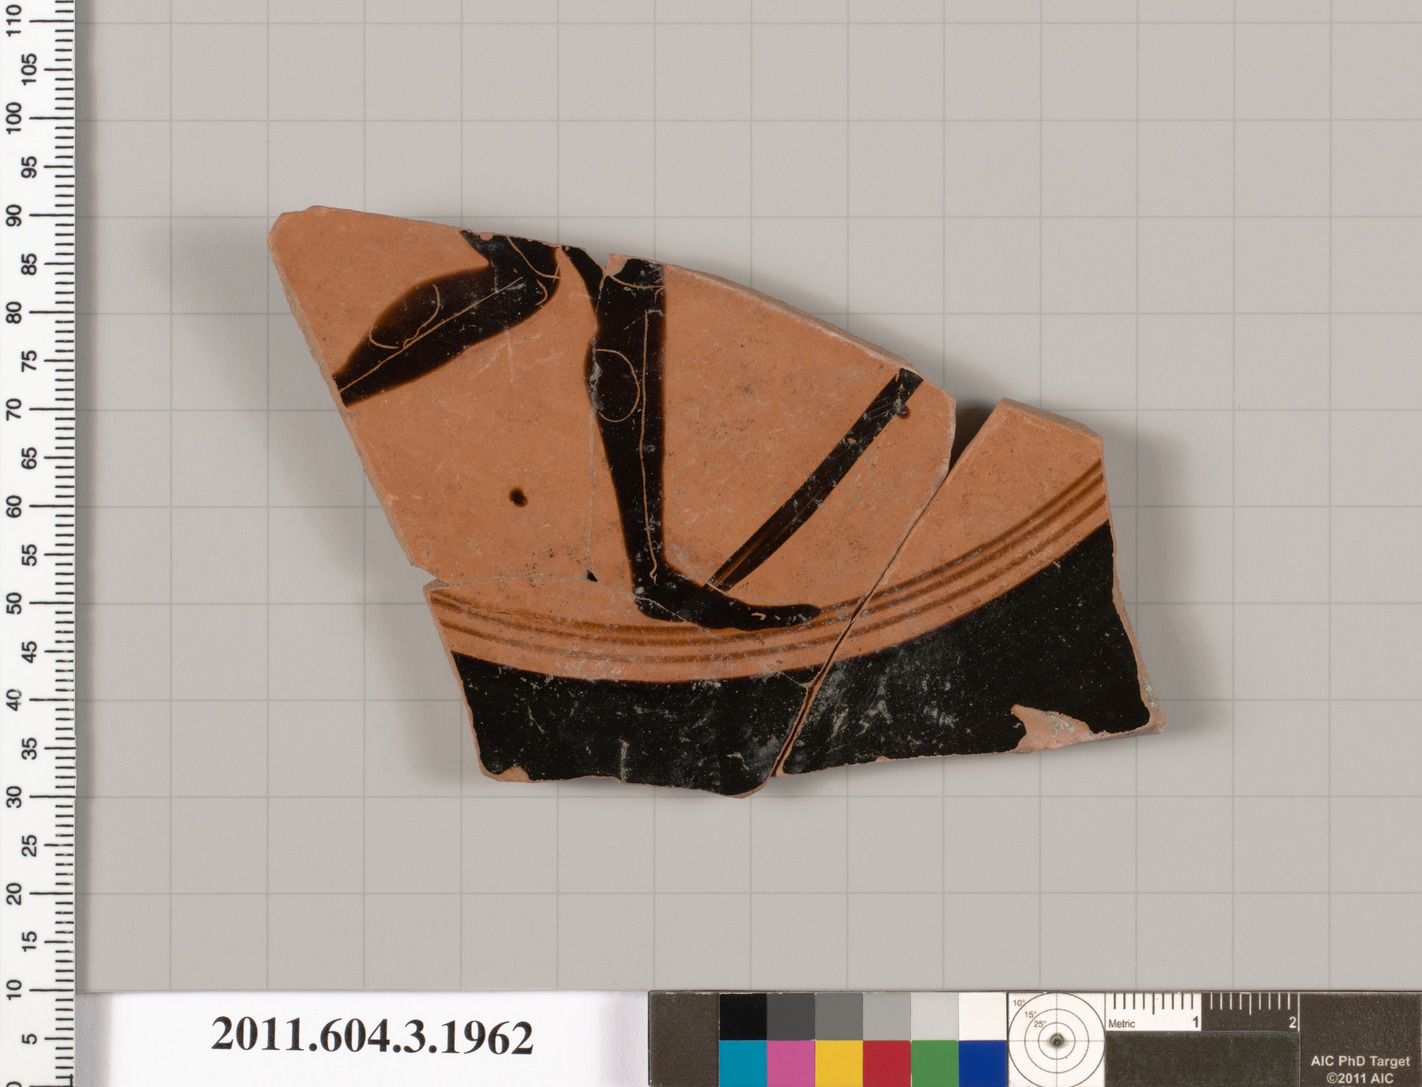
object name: kylix fragment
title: Terracotta fragment of a kylix (drinking cup)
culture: greek, attic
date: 567-535 BCE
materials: terracotta